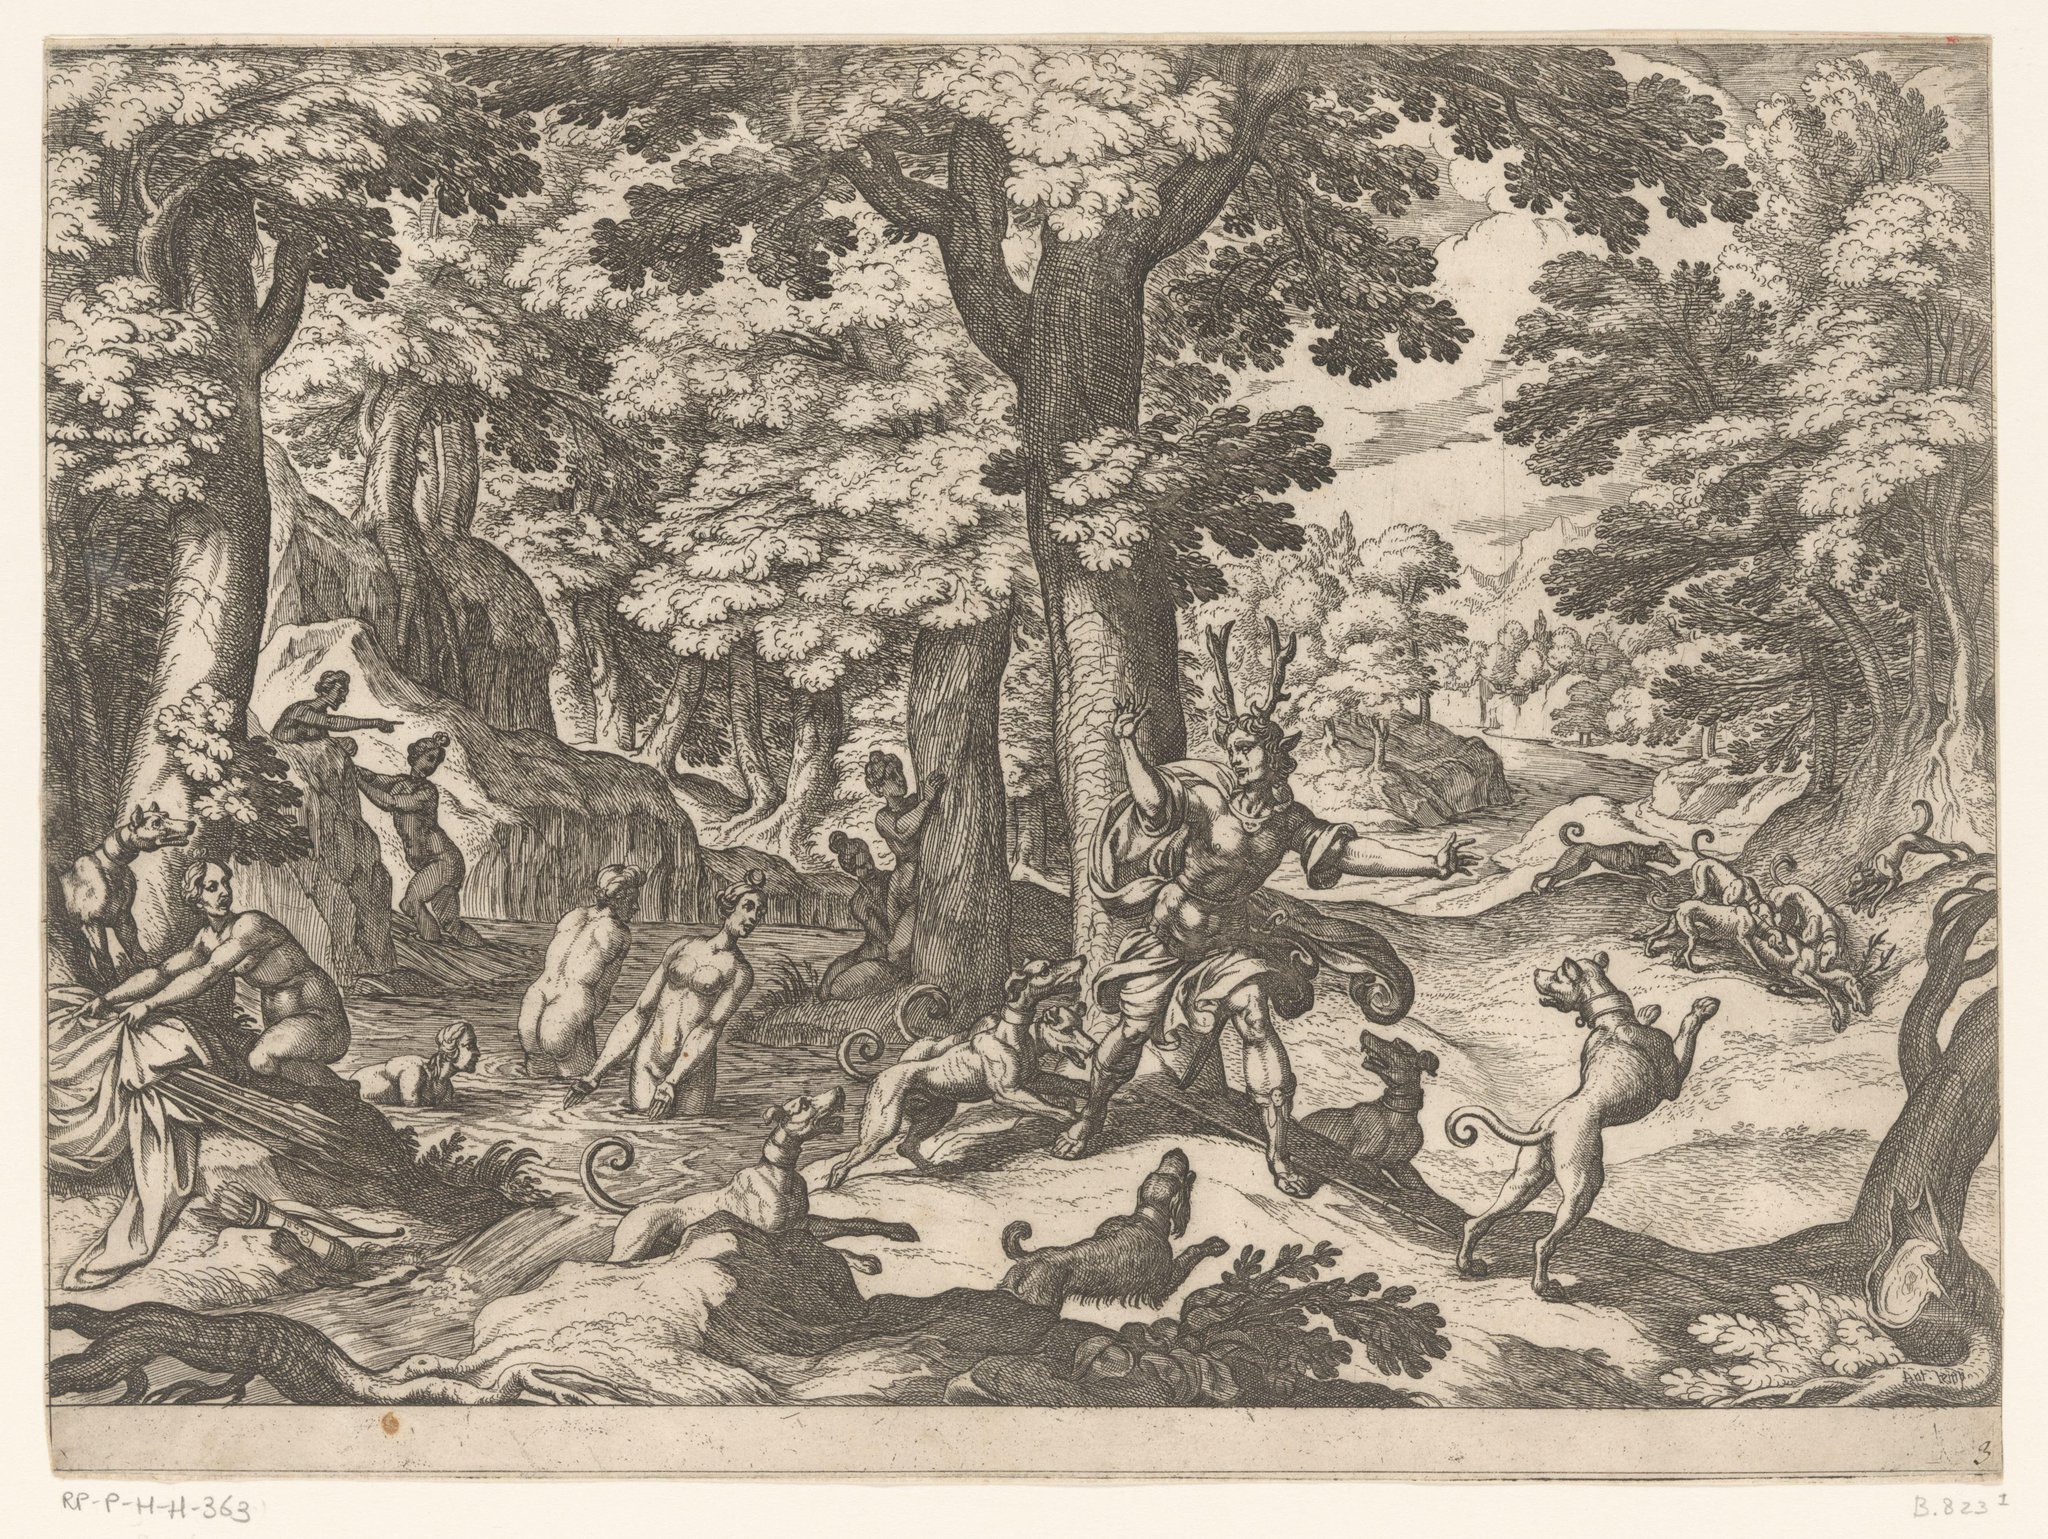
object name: print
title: Actaeon in een hert veranderd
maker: antonio tempesta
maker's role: draughtsman, painter, print maker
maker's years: 1555-1630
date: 1565-1630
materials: paper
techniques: etching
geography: italy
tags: hoofed animals: deer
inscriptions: collector's mark: Lugt 11, collector's mark: ‘Hinloopen’, number: ‘3’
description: Boslandschap met Diana en haar nimfen die baden in een waterpoel. Actaeon staat de nimfen te begluren en wordt voor straf in een hert veranderd. Actaeon krijgt een gewei en wordt achterna gezeten door zijn eigen jachthonden. Op de achtergrond rechts wordt Actaeon opgegeten door zijn honden.